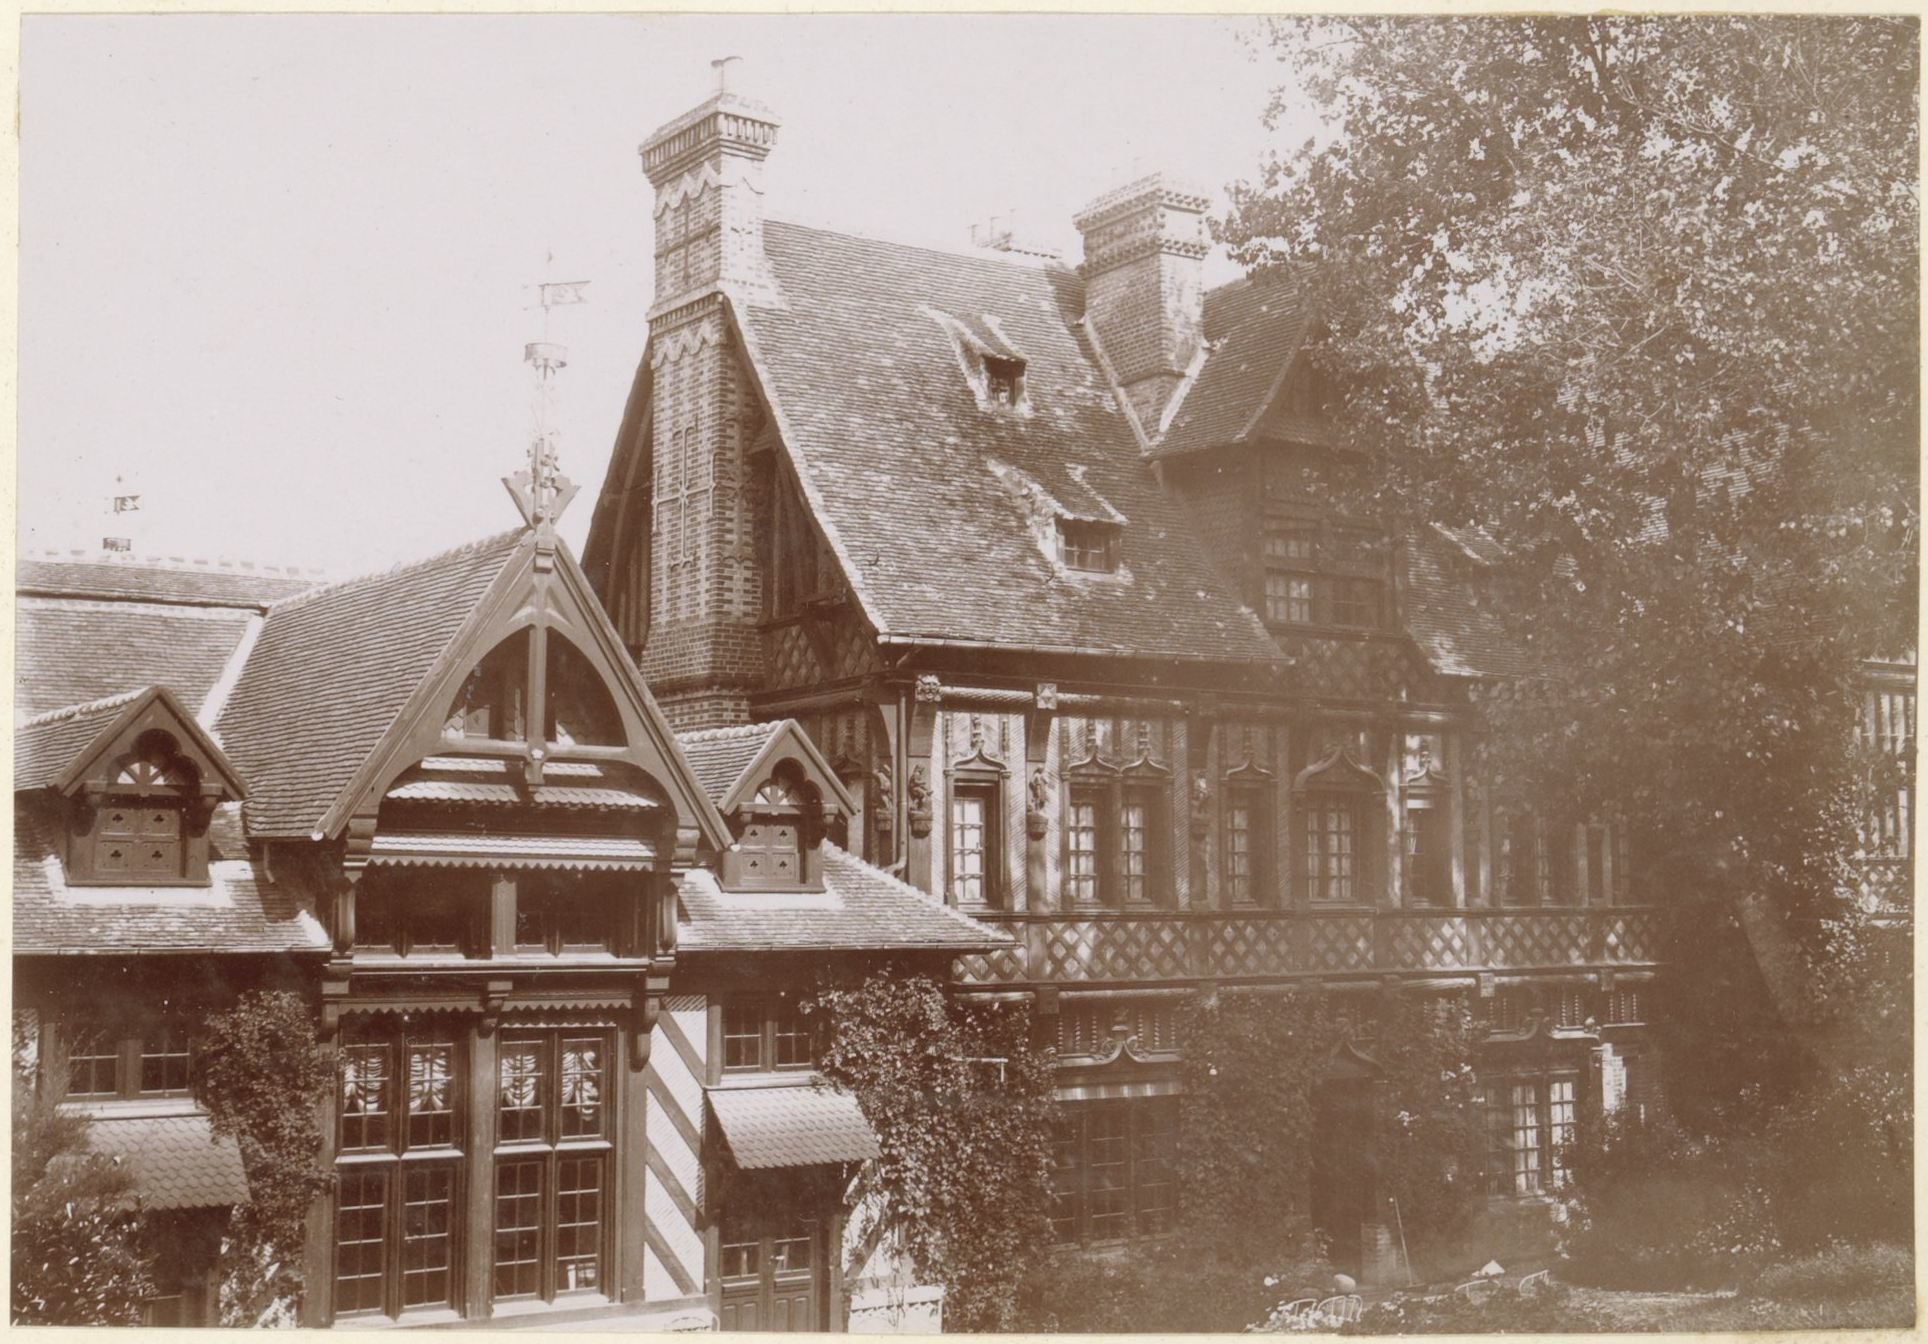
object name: photograph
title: Exterieur van een landhuis, vermoedelijk aan de Franse kust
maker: Anonymous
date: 1900-1910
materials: paper, photographic support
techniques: daylight paper print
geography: france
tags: rural housing, e.g. country-house, villa, cottage, façade (of house or building), france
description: Onderdeel van Fotoalbum van een Franse amateurfotograaf met opnames van een familie, distilleerderij Delizy & Doistau Fils, het leger en bezienswaardigheden in Frankrijk.